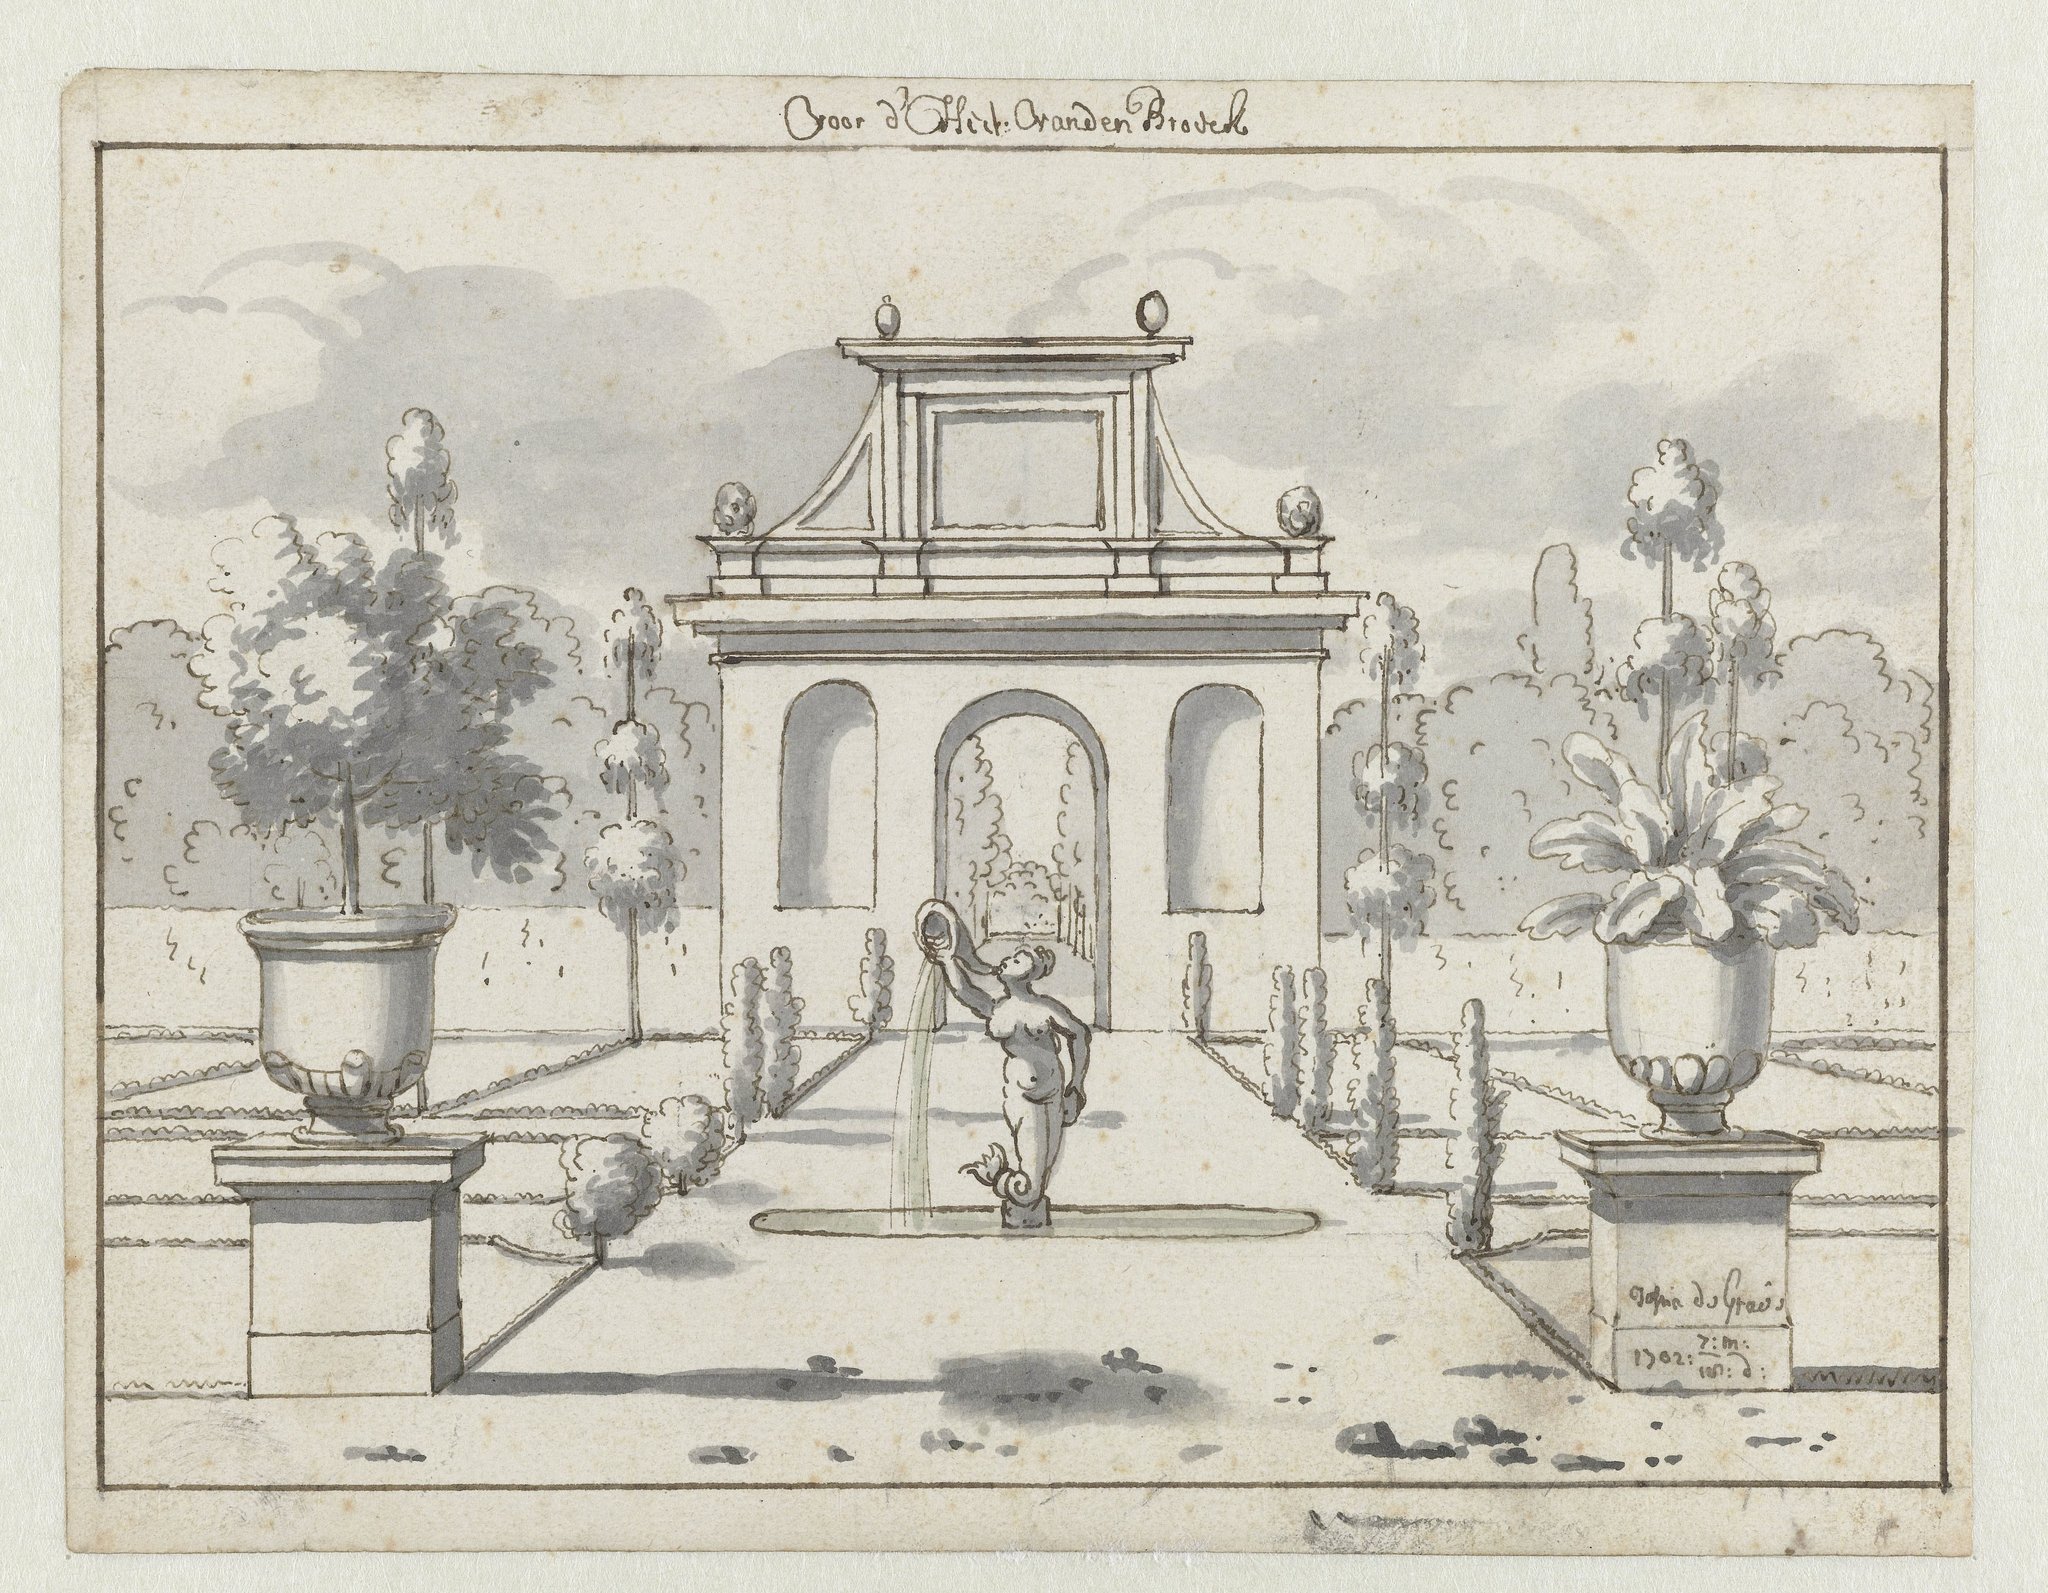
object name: drawing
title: View of a Formal Garden with an Arched Gateway and a Mermaid Fountain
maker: josua de grave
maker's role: draughtsman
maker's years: 1645-1712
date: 1702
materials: ink, paper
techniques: brush, pen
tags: merman - aa - mermaid, siren, garden fountain, garden buildings